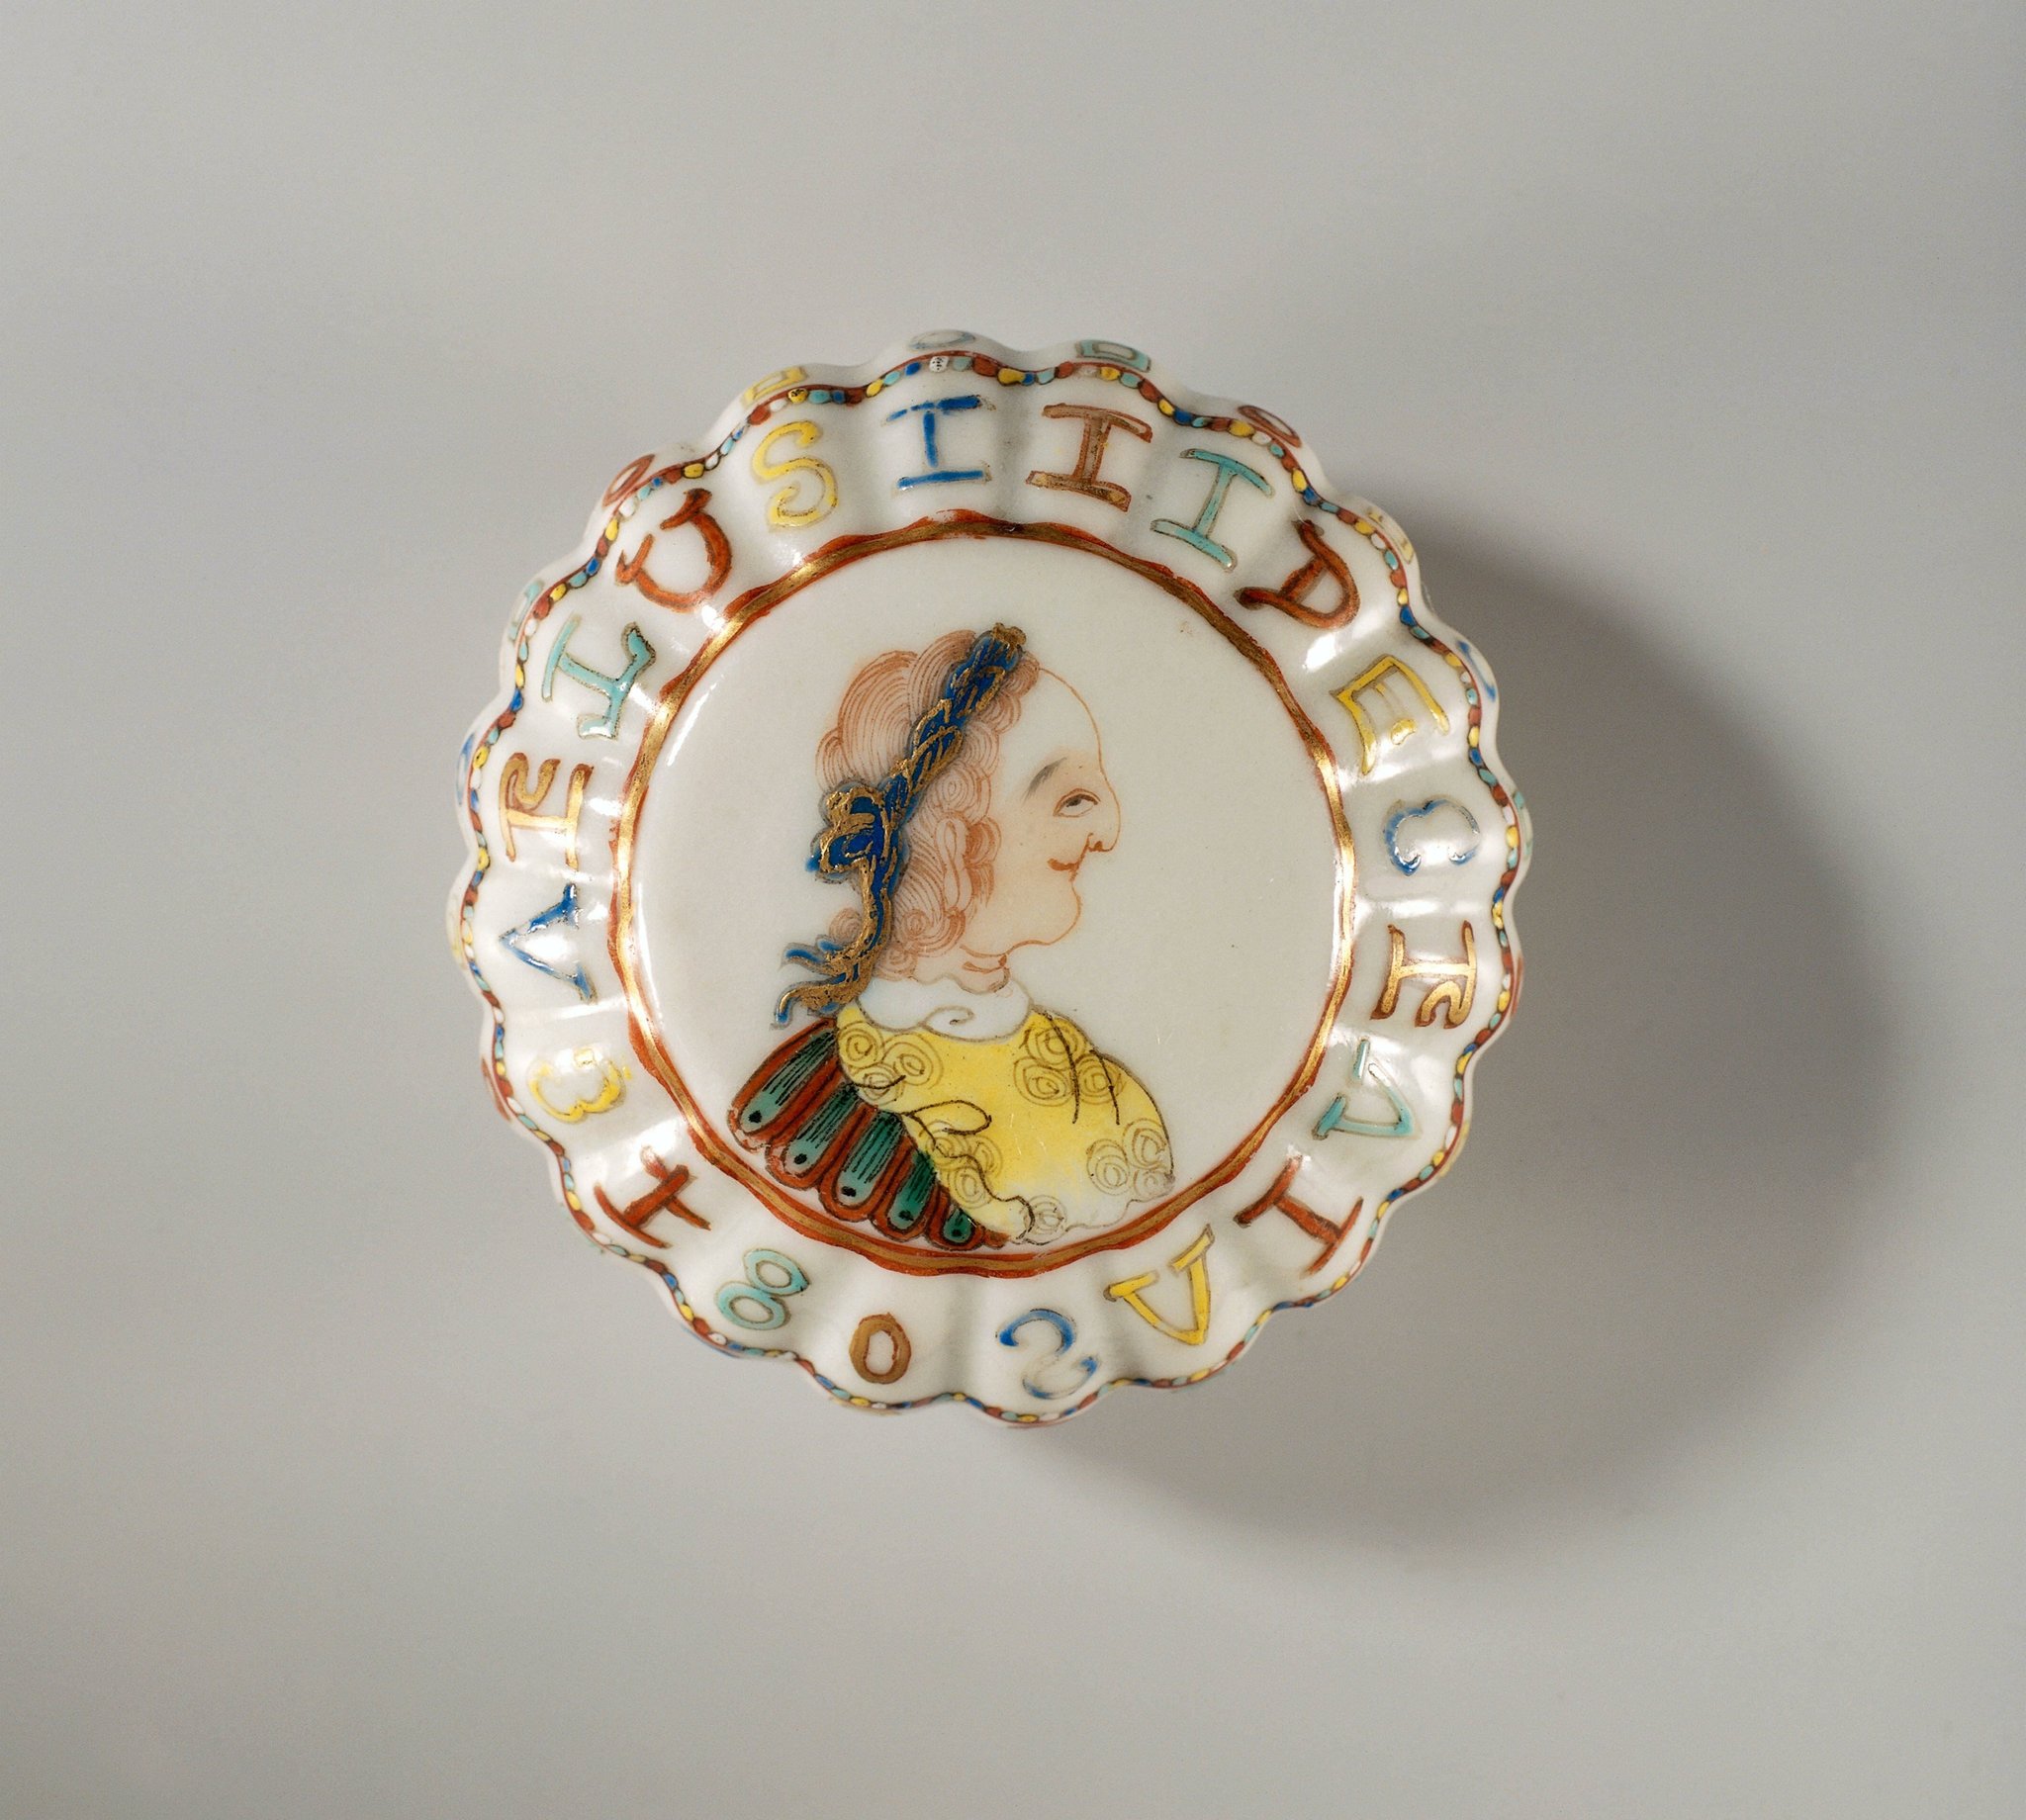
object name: box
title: Covered box with a portrait of Charles III of Spain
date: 1875-1899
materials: glaze, gold, paint, porcelain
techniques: firing, gilding, turning, vitrification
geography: china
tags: karel iii (koning van spanje (1716-1788)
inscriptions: inscription: ‘CAROLUS III DEI GRATA 1802’, inscription: ‘HISPAN ET IND REX A 8 REHO’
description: Doos met geribde zijden en een gewelfd deksel op een voetring. Gedecoreerd in emailkleuren. Op de bovenkant een portret van Karel III van Spanje, op de onderkant het wapen van Karel III. Rondom het portret de inscriptie CAROLUS III DEI GRATA 1802. Rondom het wapen de inscriptie HISPA ET IND REX A 8 REHO. Aan de binnenkant van de deksel en de doos een bloem in een gele emailkleur. Het voorbeeld van de afbeeldingen voor deze doos was een zilveren Spaanse reaal. Vanaf de late Middeleeuwen was de reaal een veelgebruikt betaalmiddel. De kleuren en de manier waarop deze zijn aangebracht roepen vragen op: het zou een 19de-eeuwse kopie kunnen zijn, vervaardigd in de fabriek Samson te Parijs. Deze fabriek was gespecialiseerd in het namaken van oosters porselein.